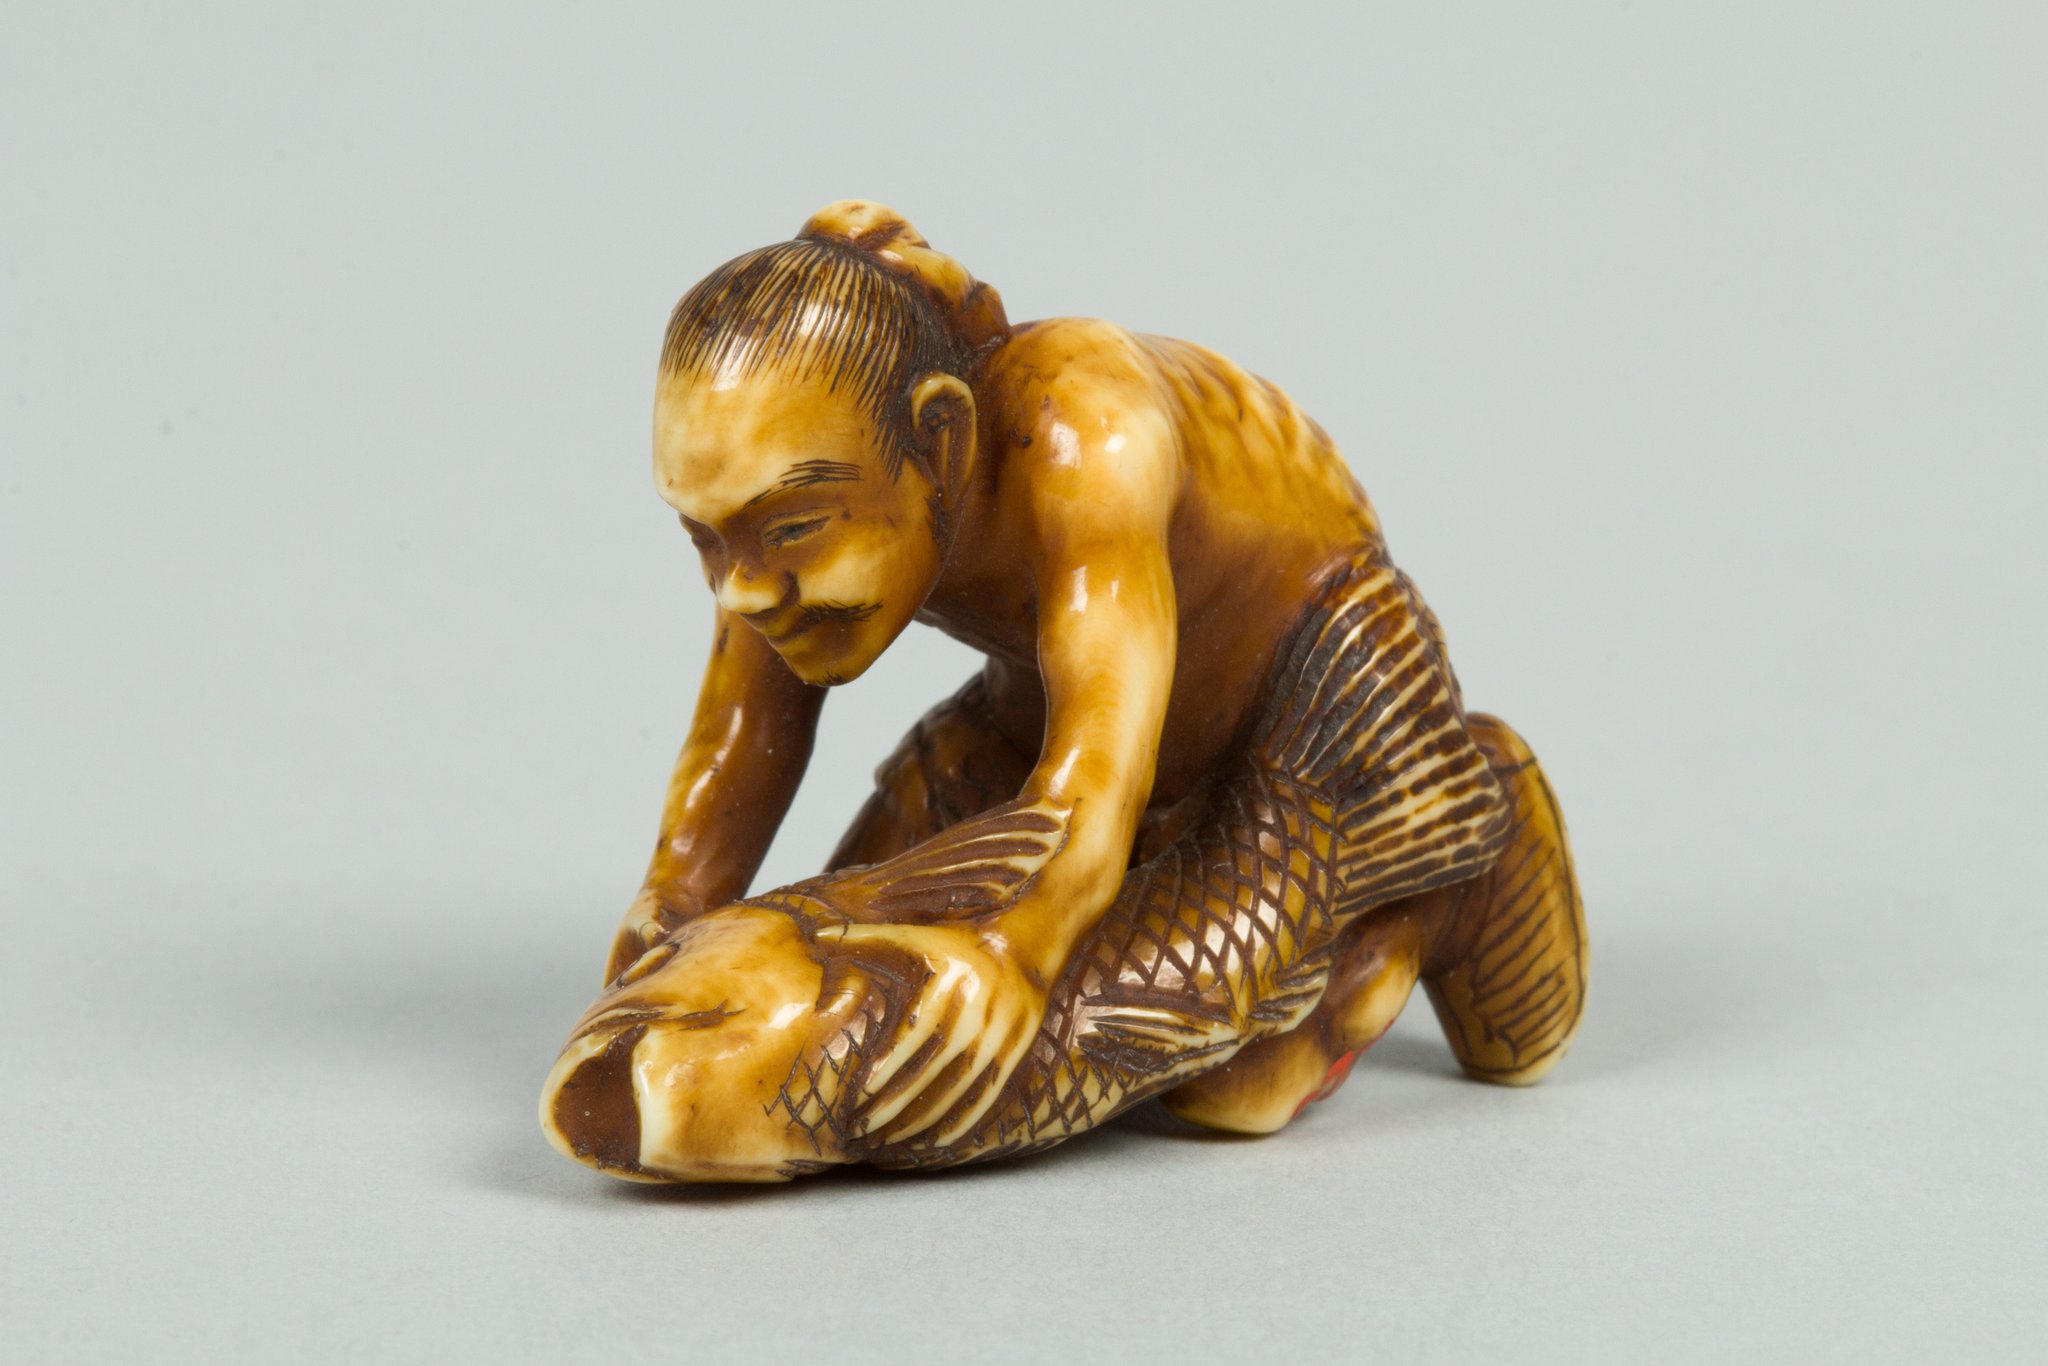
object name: netsuke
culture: japanese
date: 1801-1900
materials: ivory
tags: men,fish